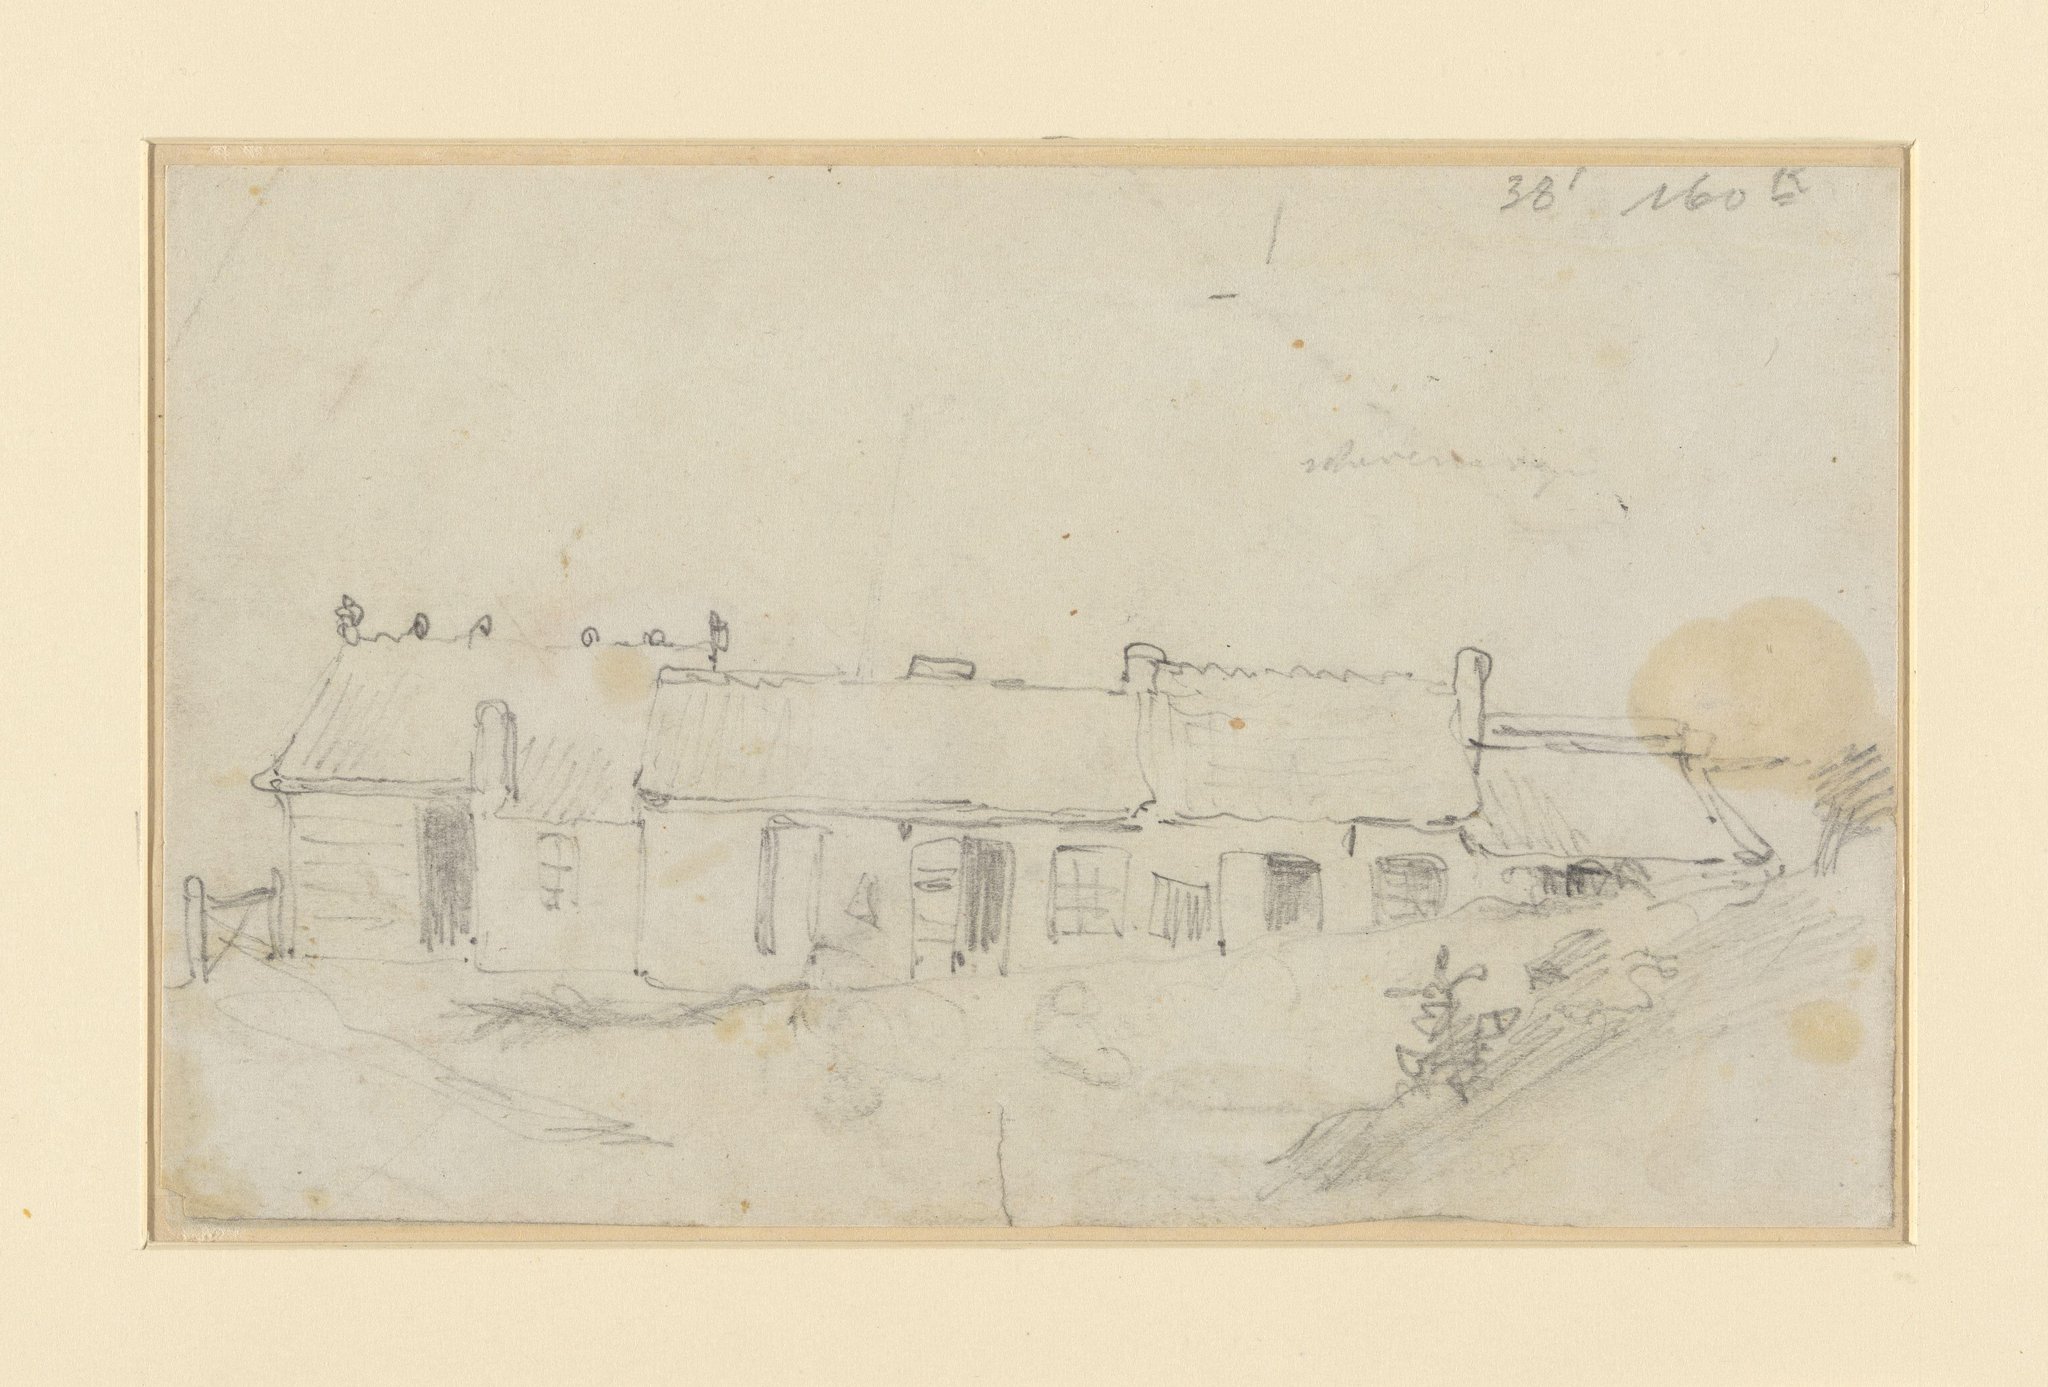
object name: drawing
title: Huizen te Scheveningen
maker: jan weissenbruch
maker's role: painter, print maker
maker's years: 1822-1880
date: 1832-1880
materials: paper, pencil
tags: urban housing